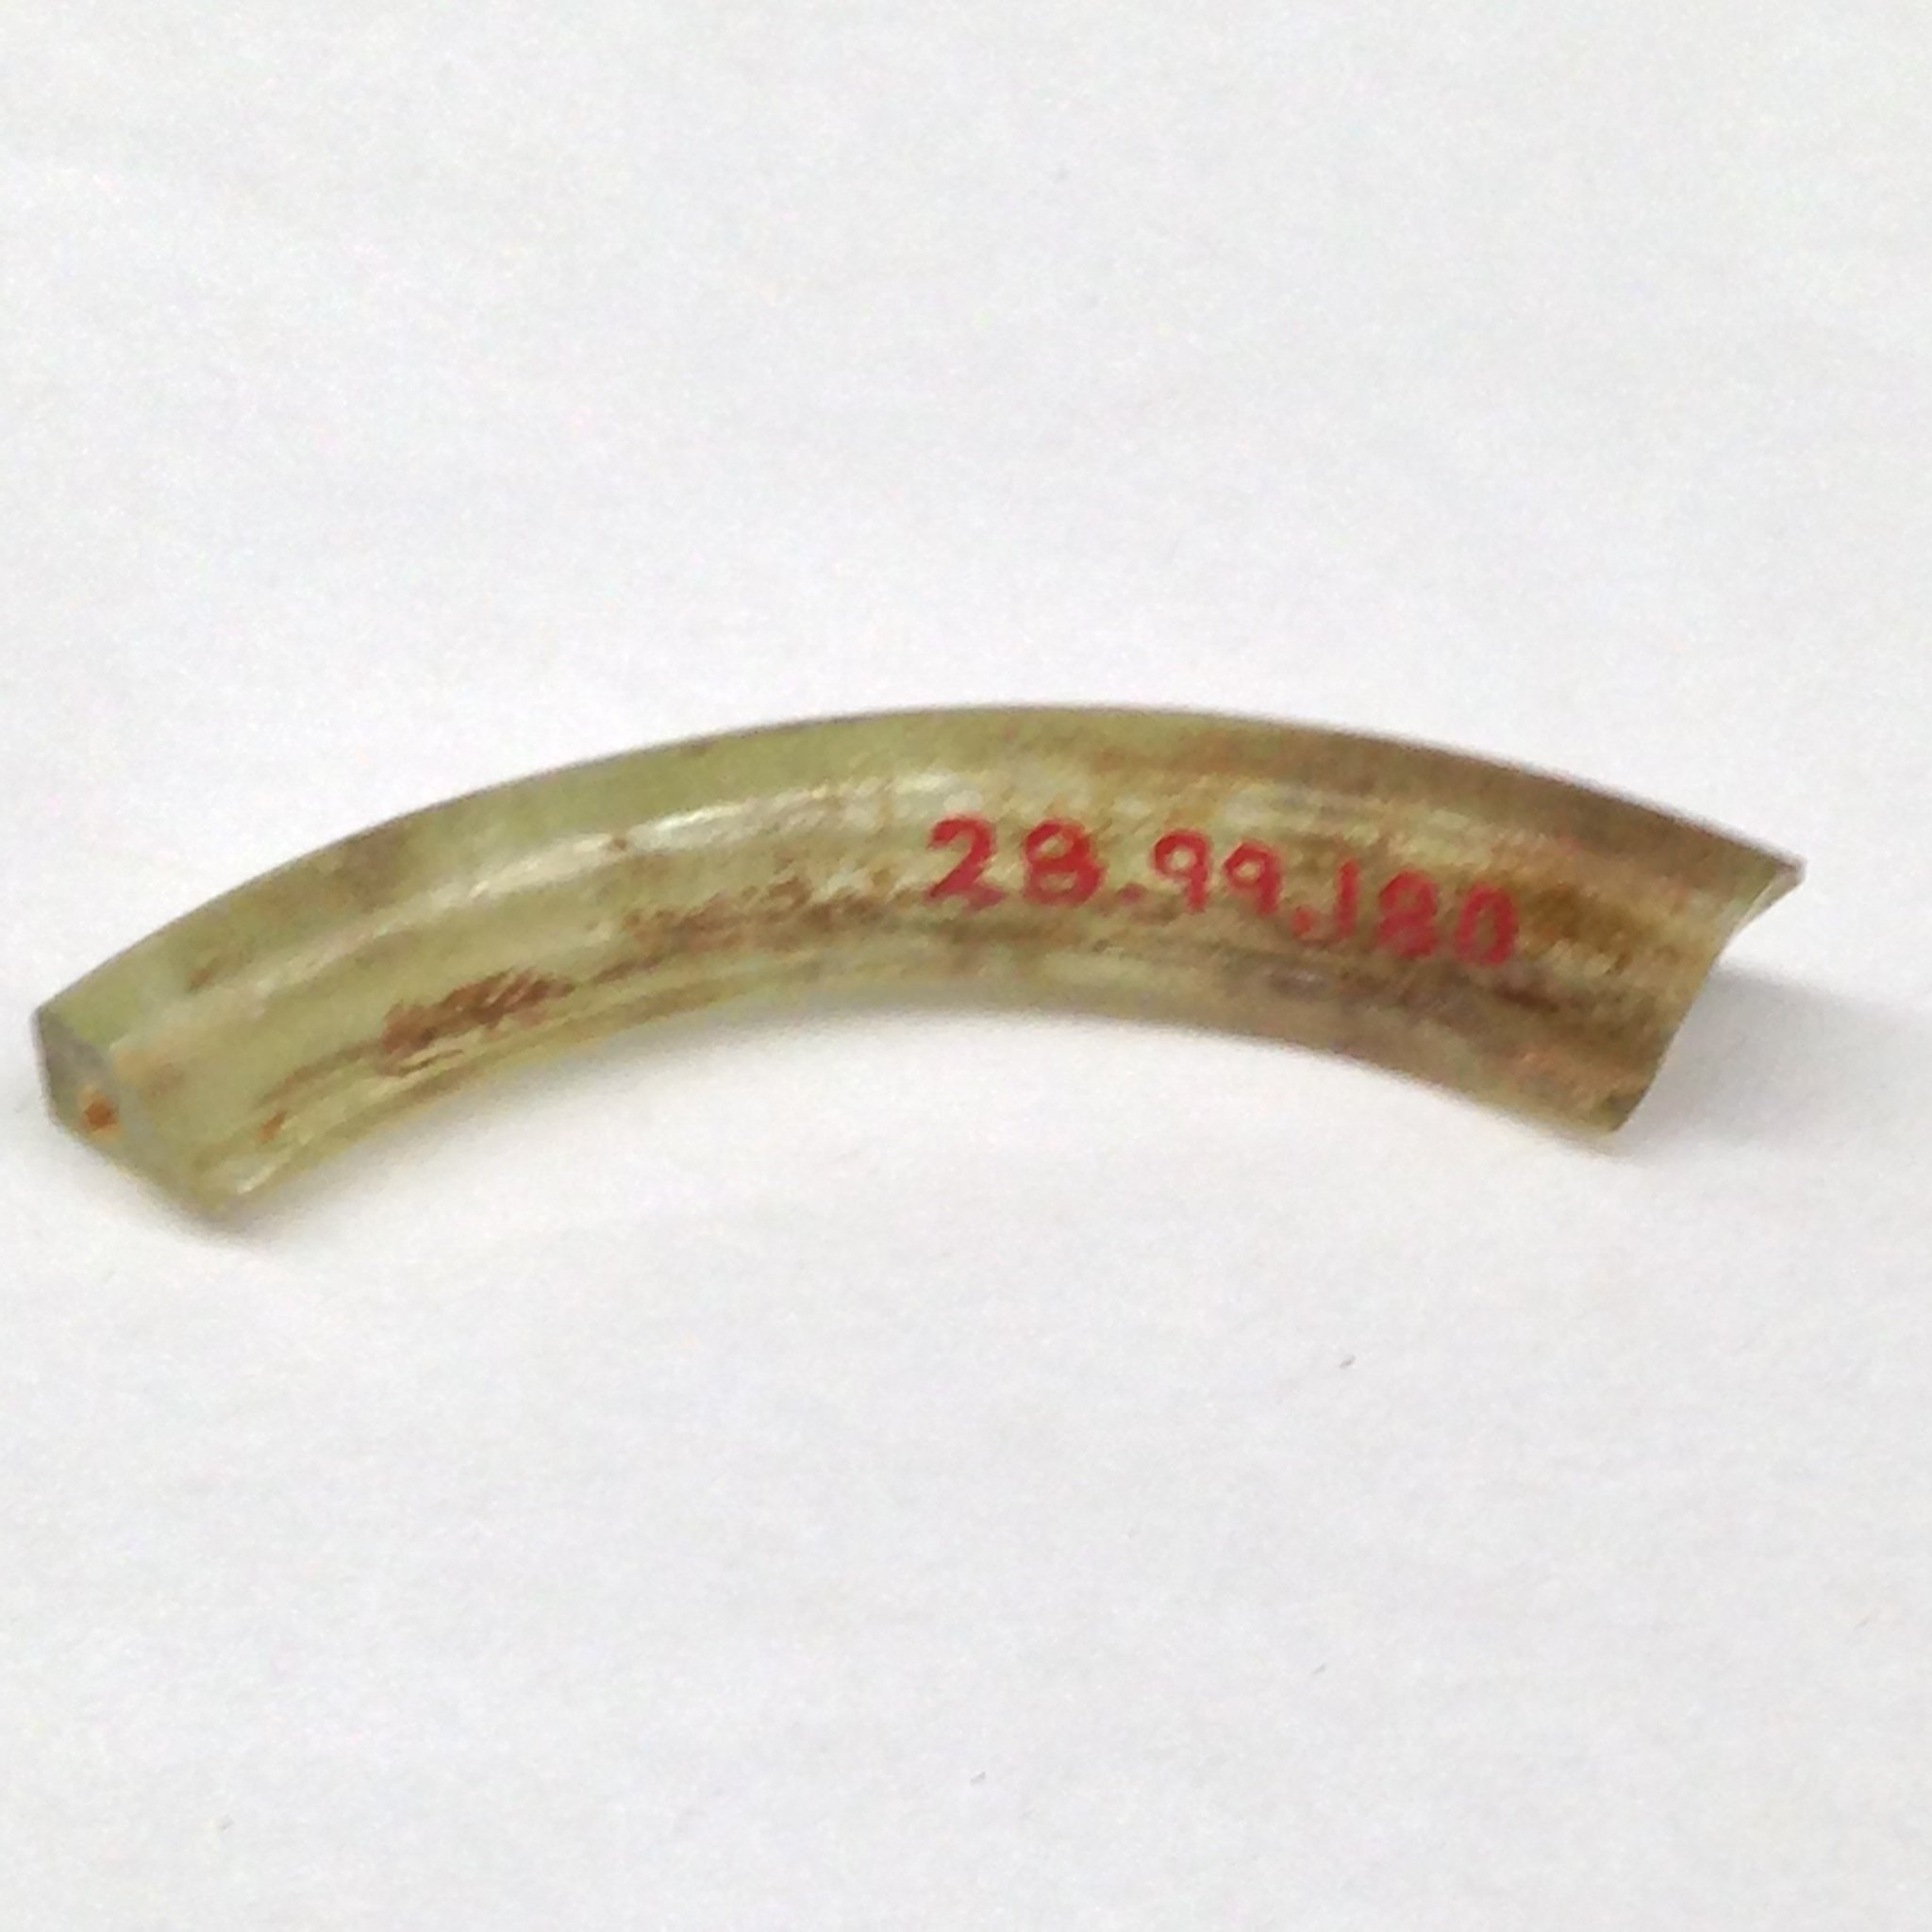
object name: fragment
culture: european or middle eastern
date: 1150-1250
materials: ceramic, glass